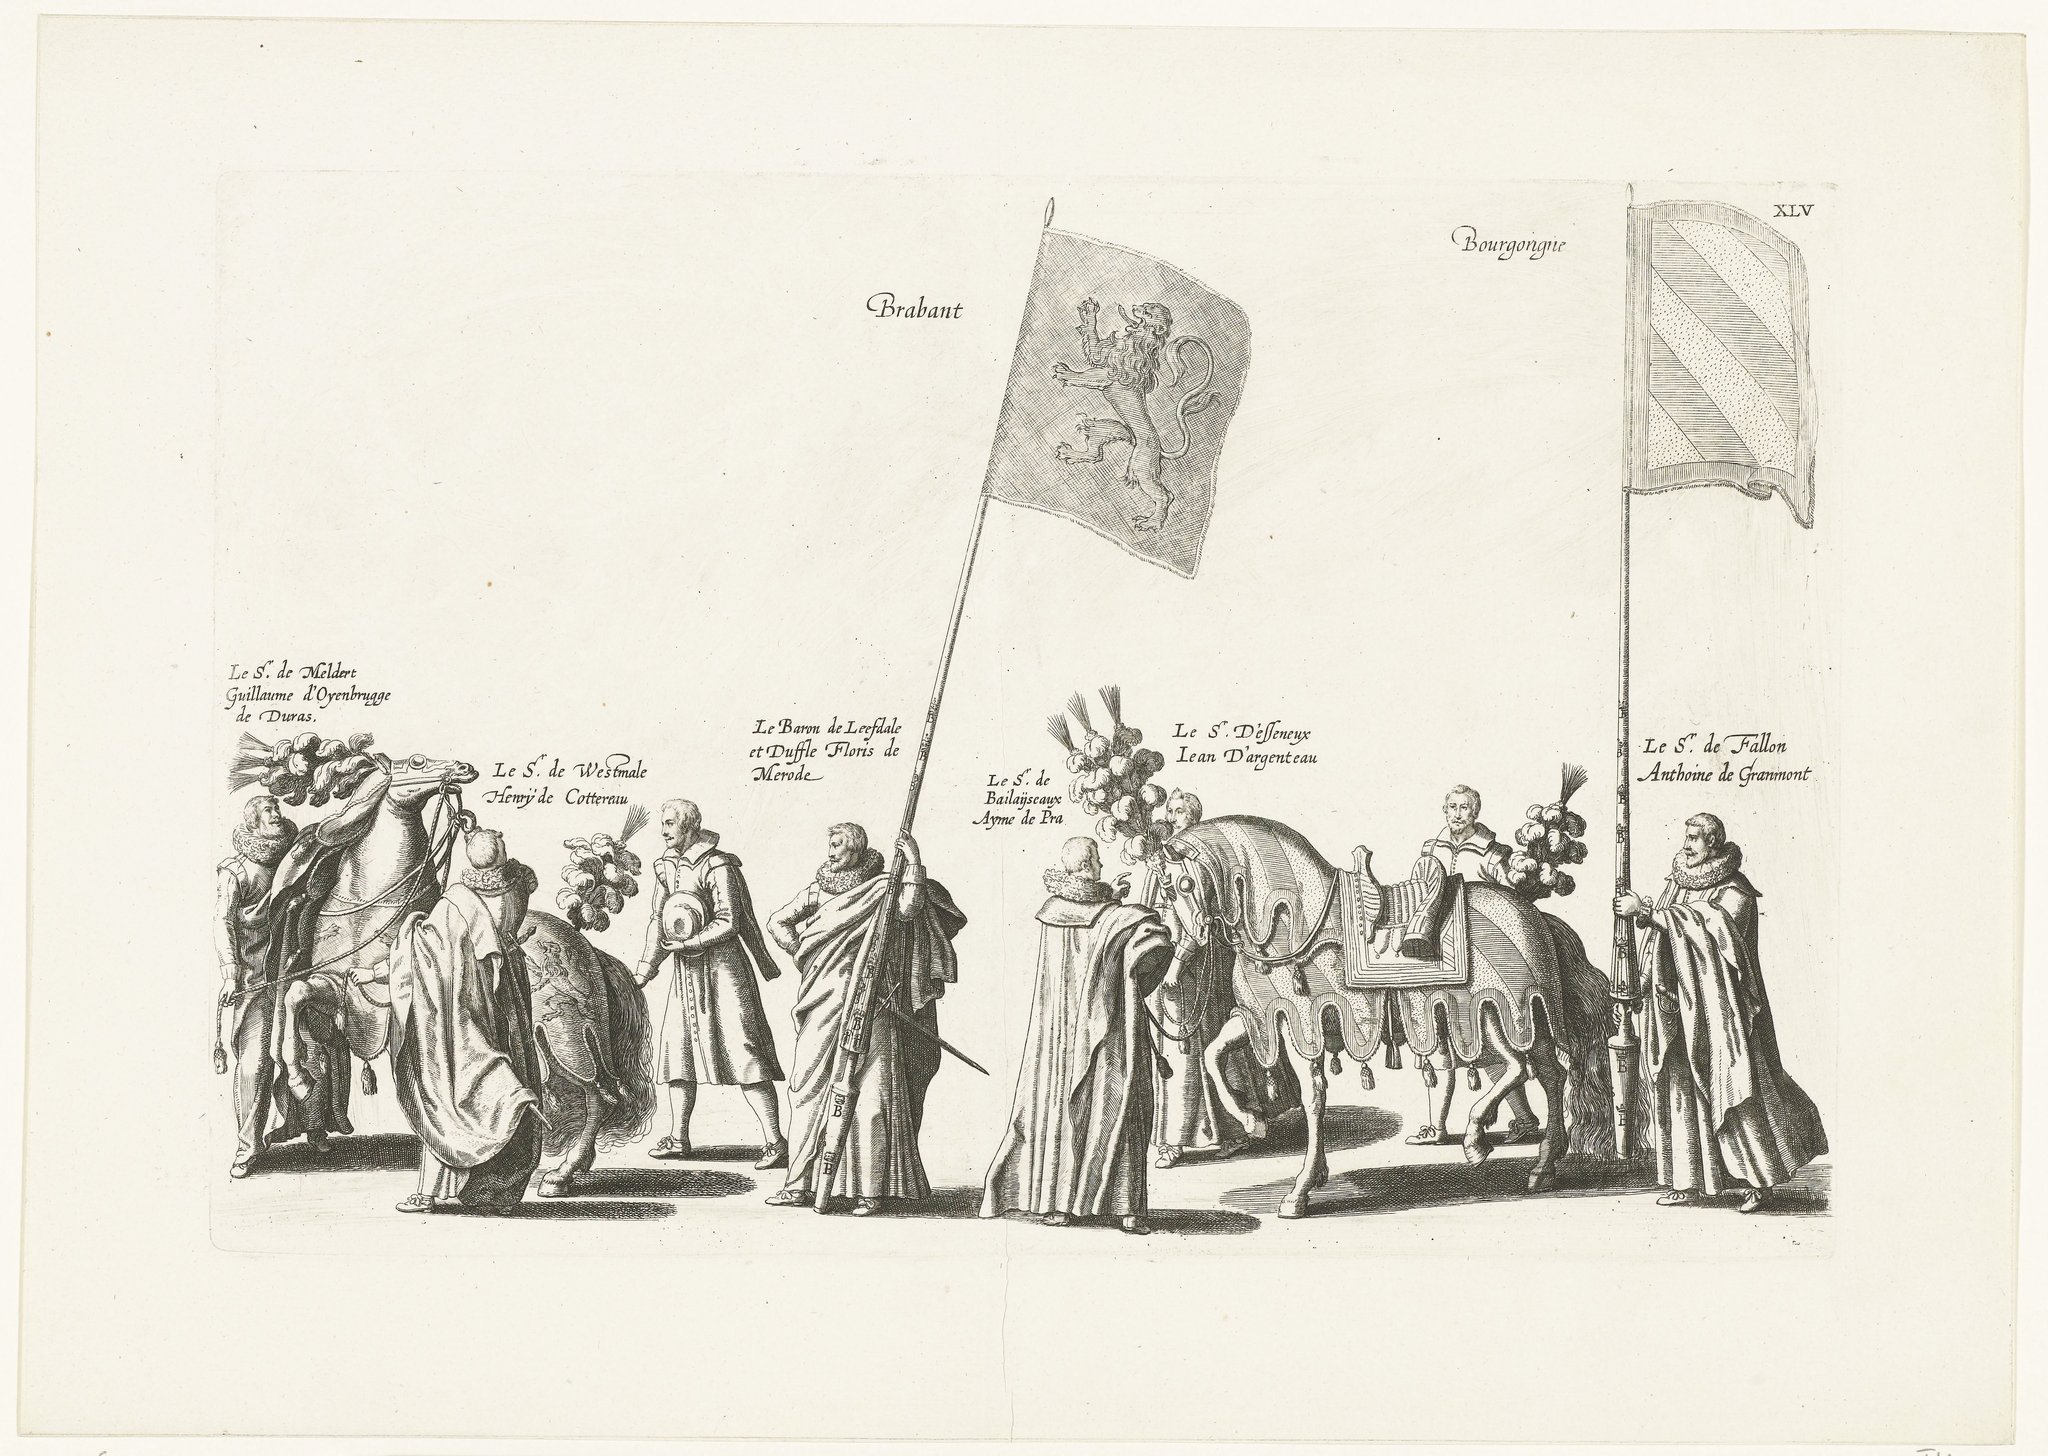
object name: print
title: Brabant / Bourgongne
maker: cornelis galle (i)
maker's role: print maker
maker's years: 1576-1650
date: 1623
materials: paper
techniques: etching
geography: southern netherlands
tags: brussels, albrecht aartshertog van oostenrijk, cortege, funeral procession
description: Deelnemers in de begrafenisstoet met de vaandels van Brabant en Bourgondië. Plaat XLV in de serie van de begrafenis van aartshertog Albrecht van Oostenrijk te Brussel op 12 maart 1622.